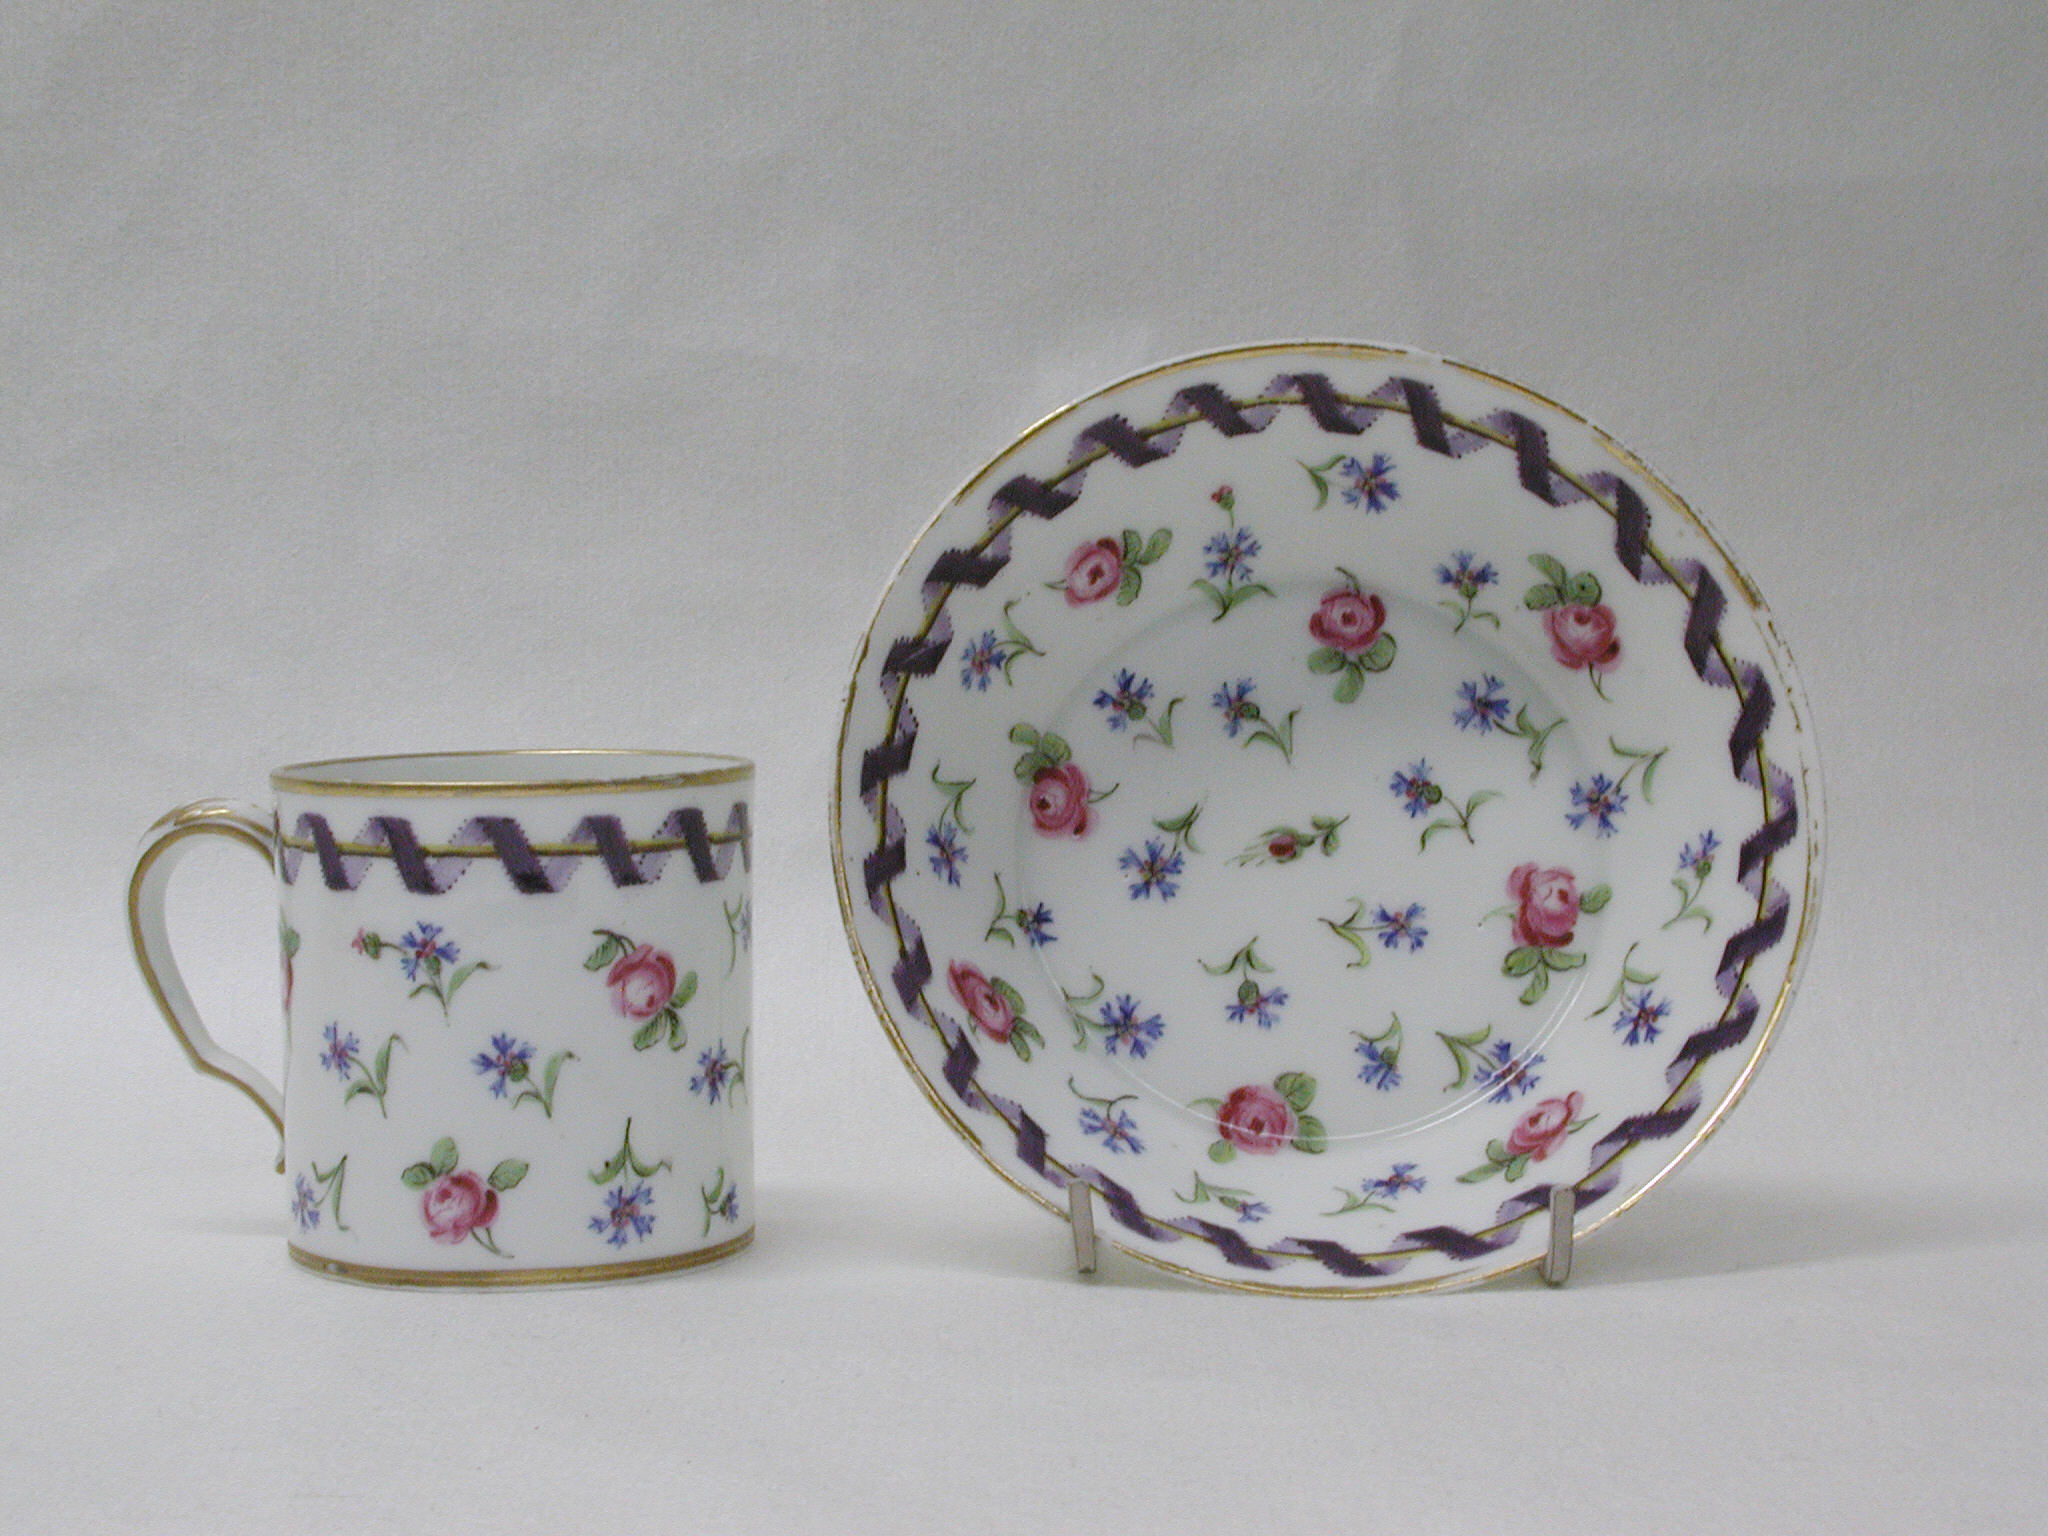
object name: cup and saucer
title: Cup and saucer (gobelet litron et soucoupe)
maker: sèvres manufactory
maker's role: manufactory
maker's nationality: french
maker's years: 1740-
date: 1800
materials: soft paste porcelain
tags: flowers